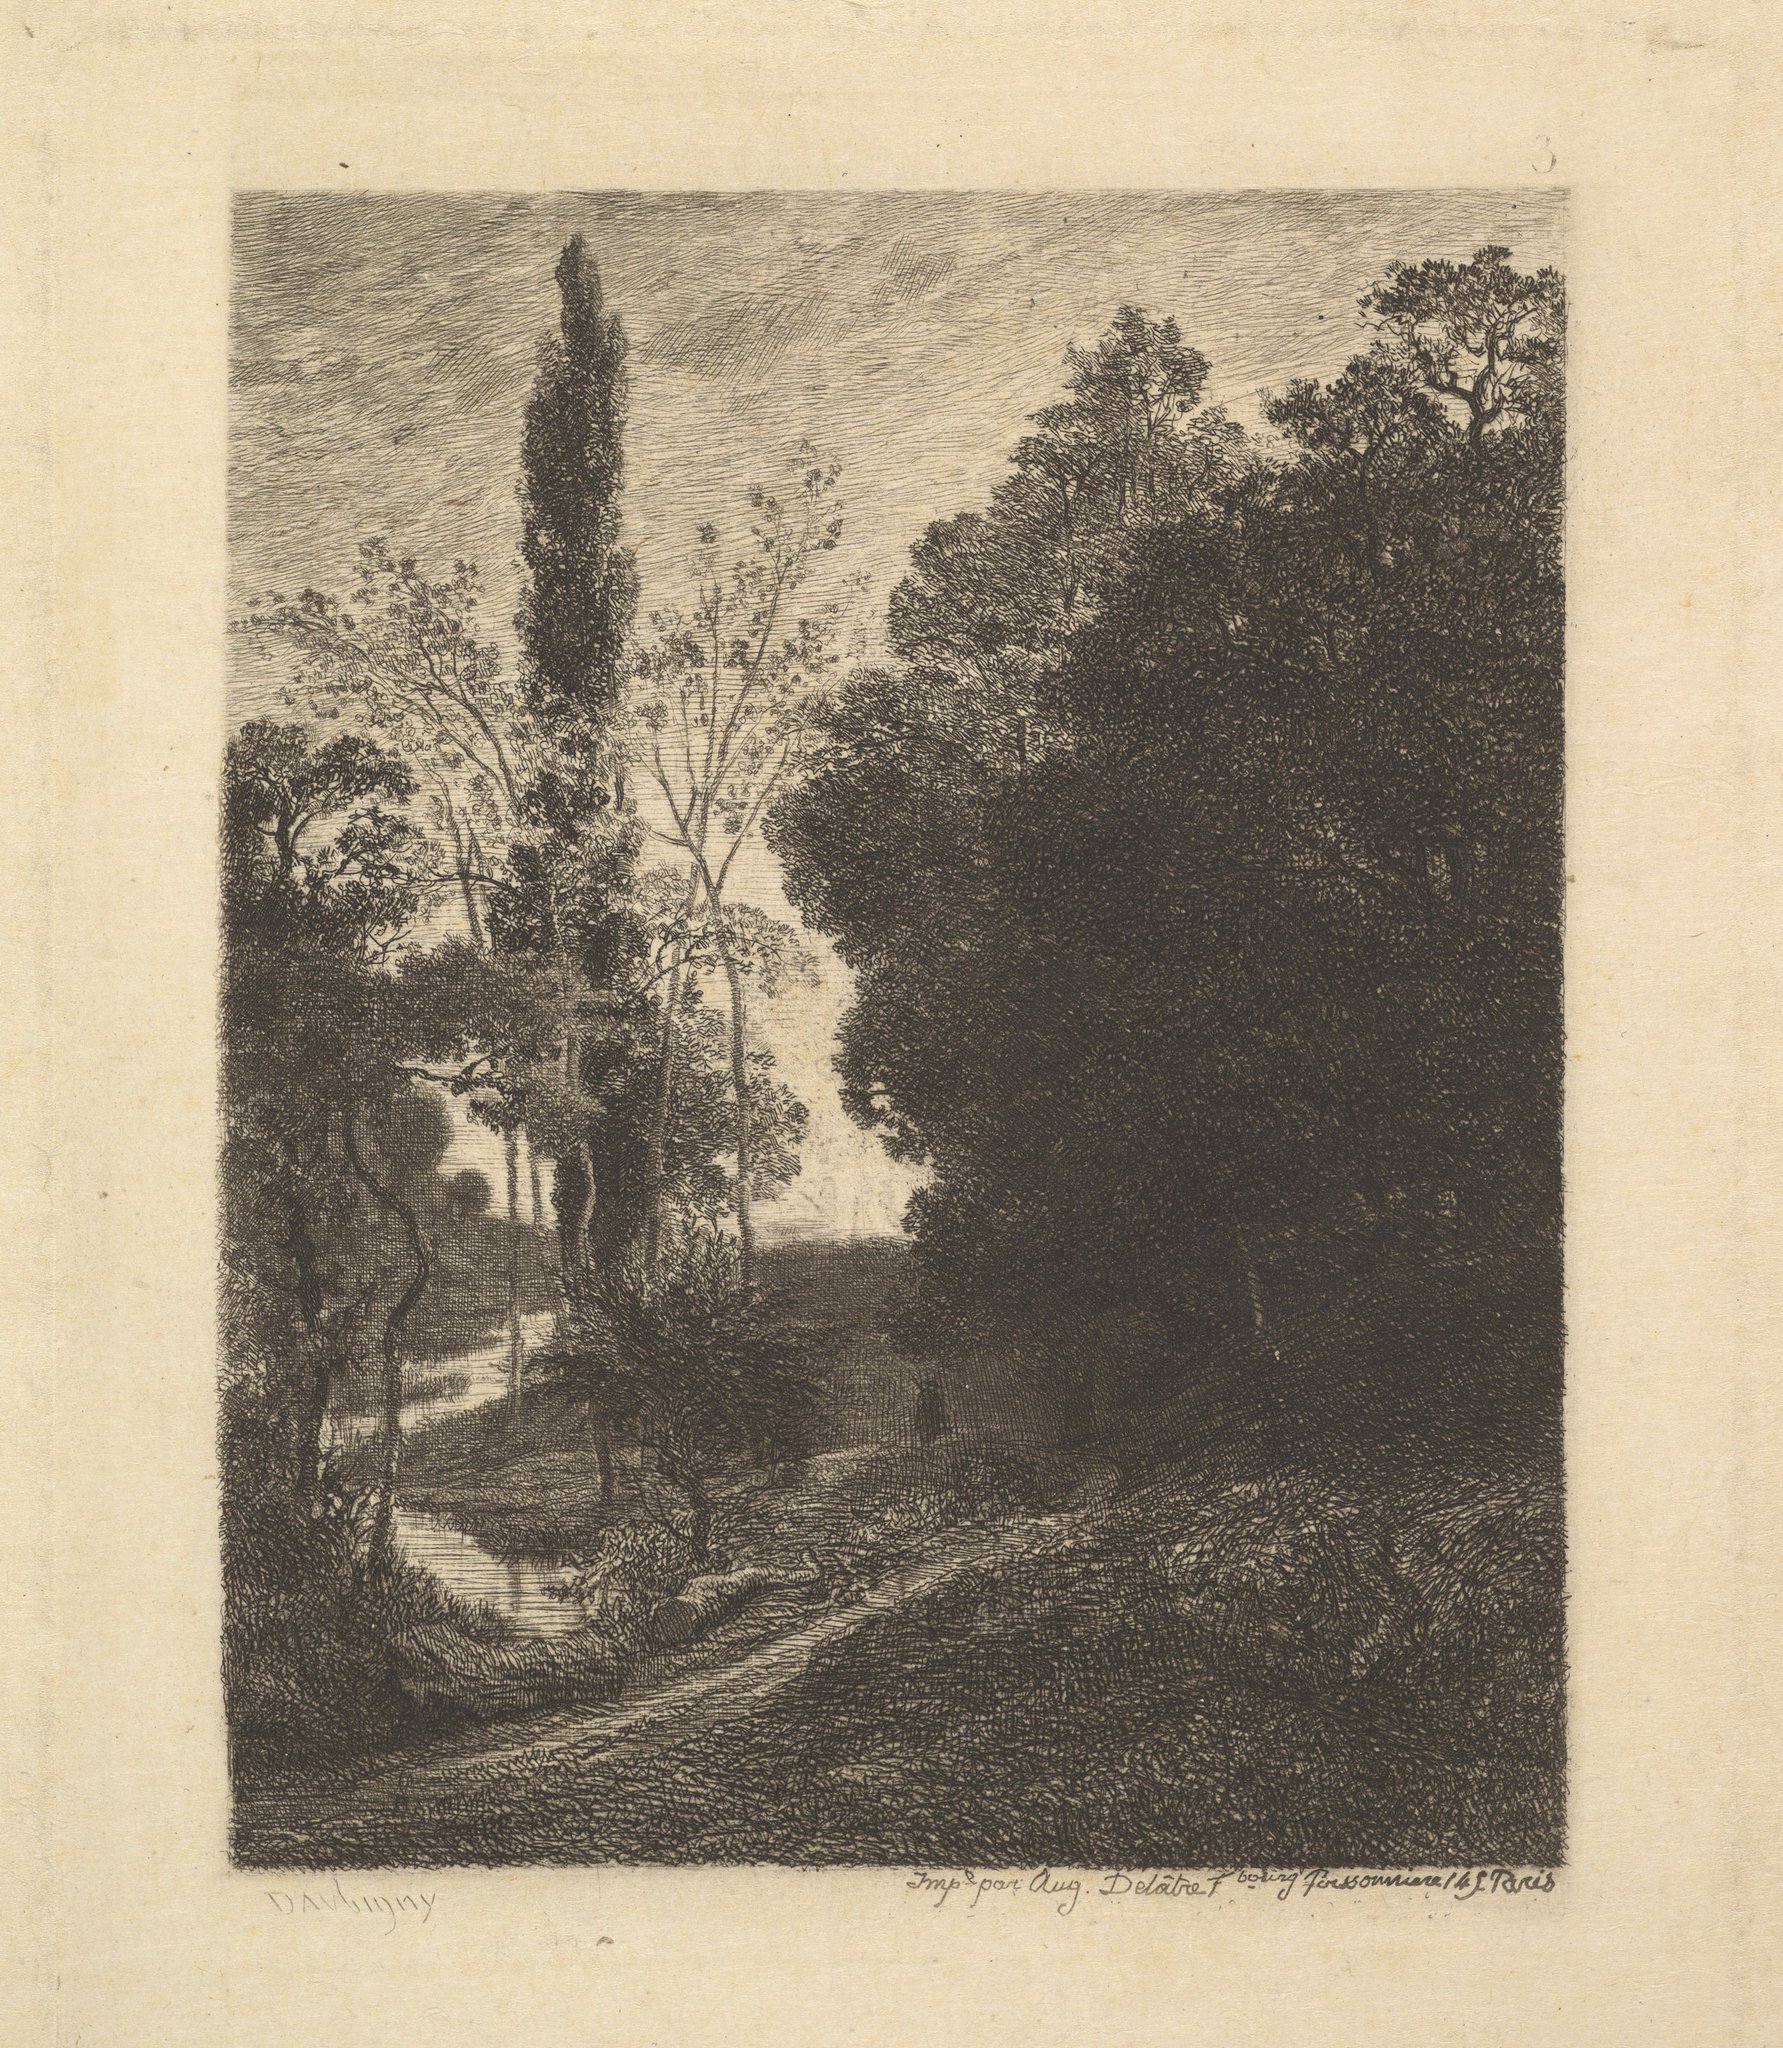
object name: print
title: The Banks of Cousin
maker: charles-françois daubigny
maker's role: artist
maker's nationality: french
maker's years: 1817-1878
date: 1850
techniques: etching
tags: trees